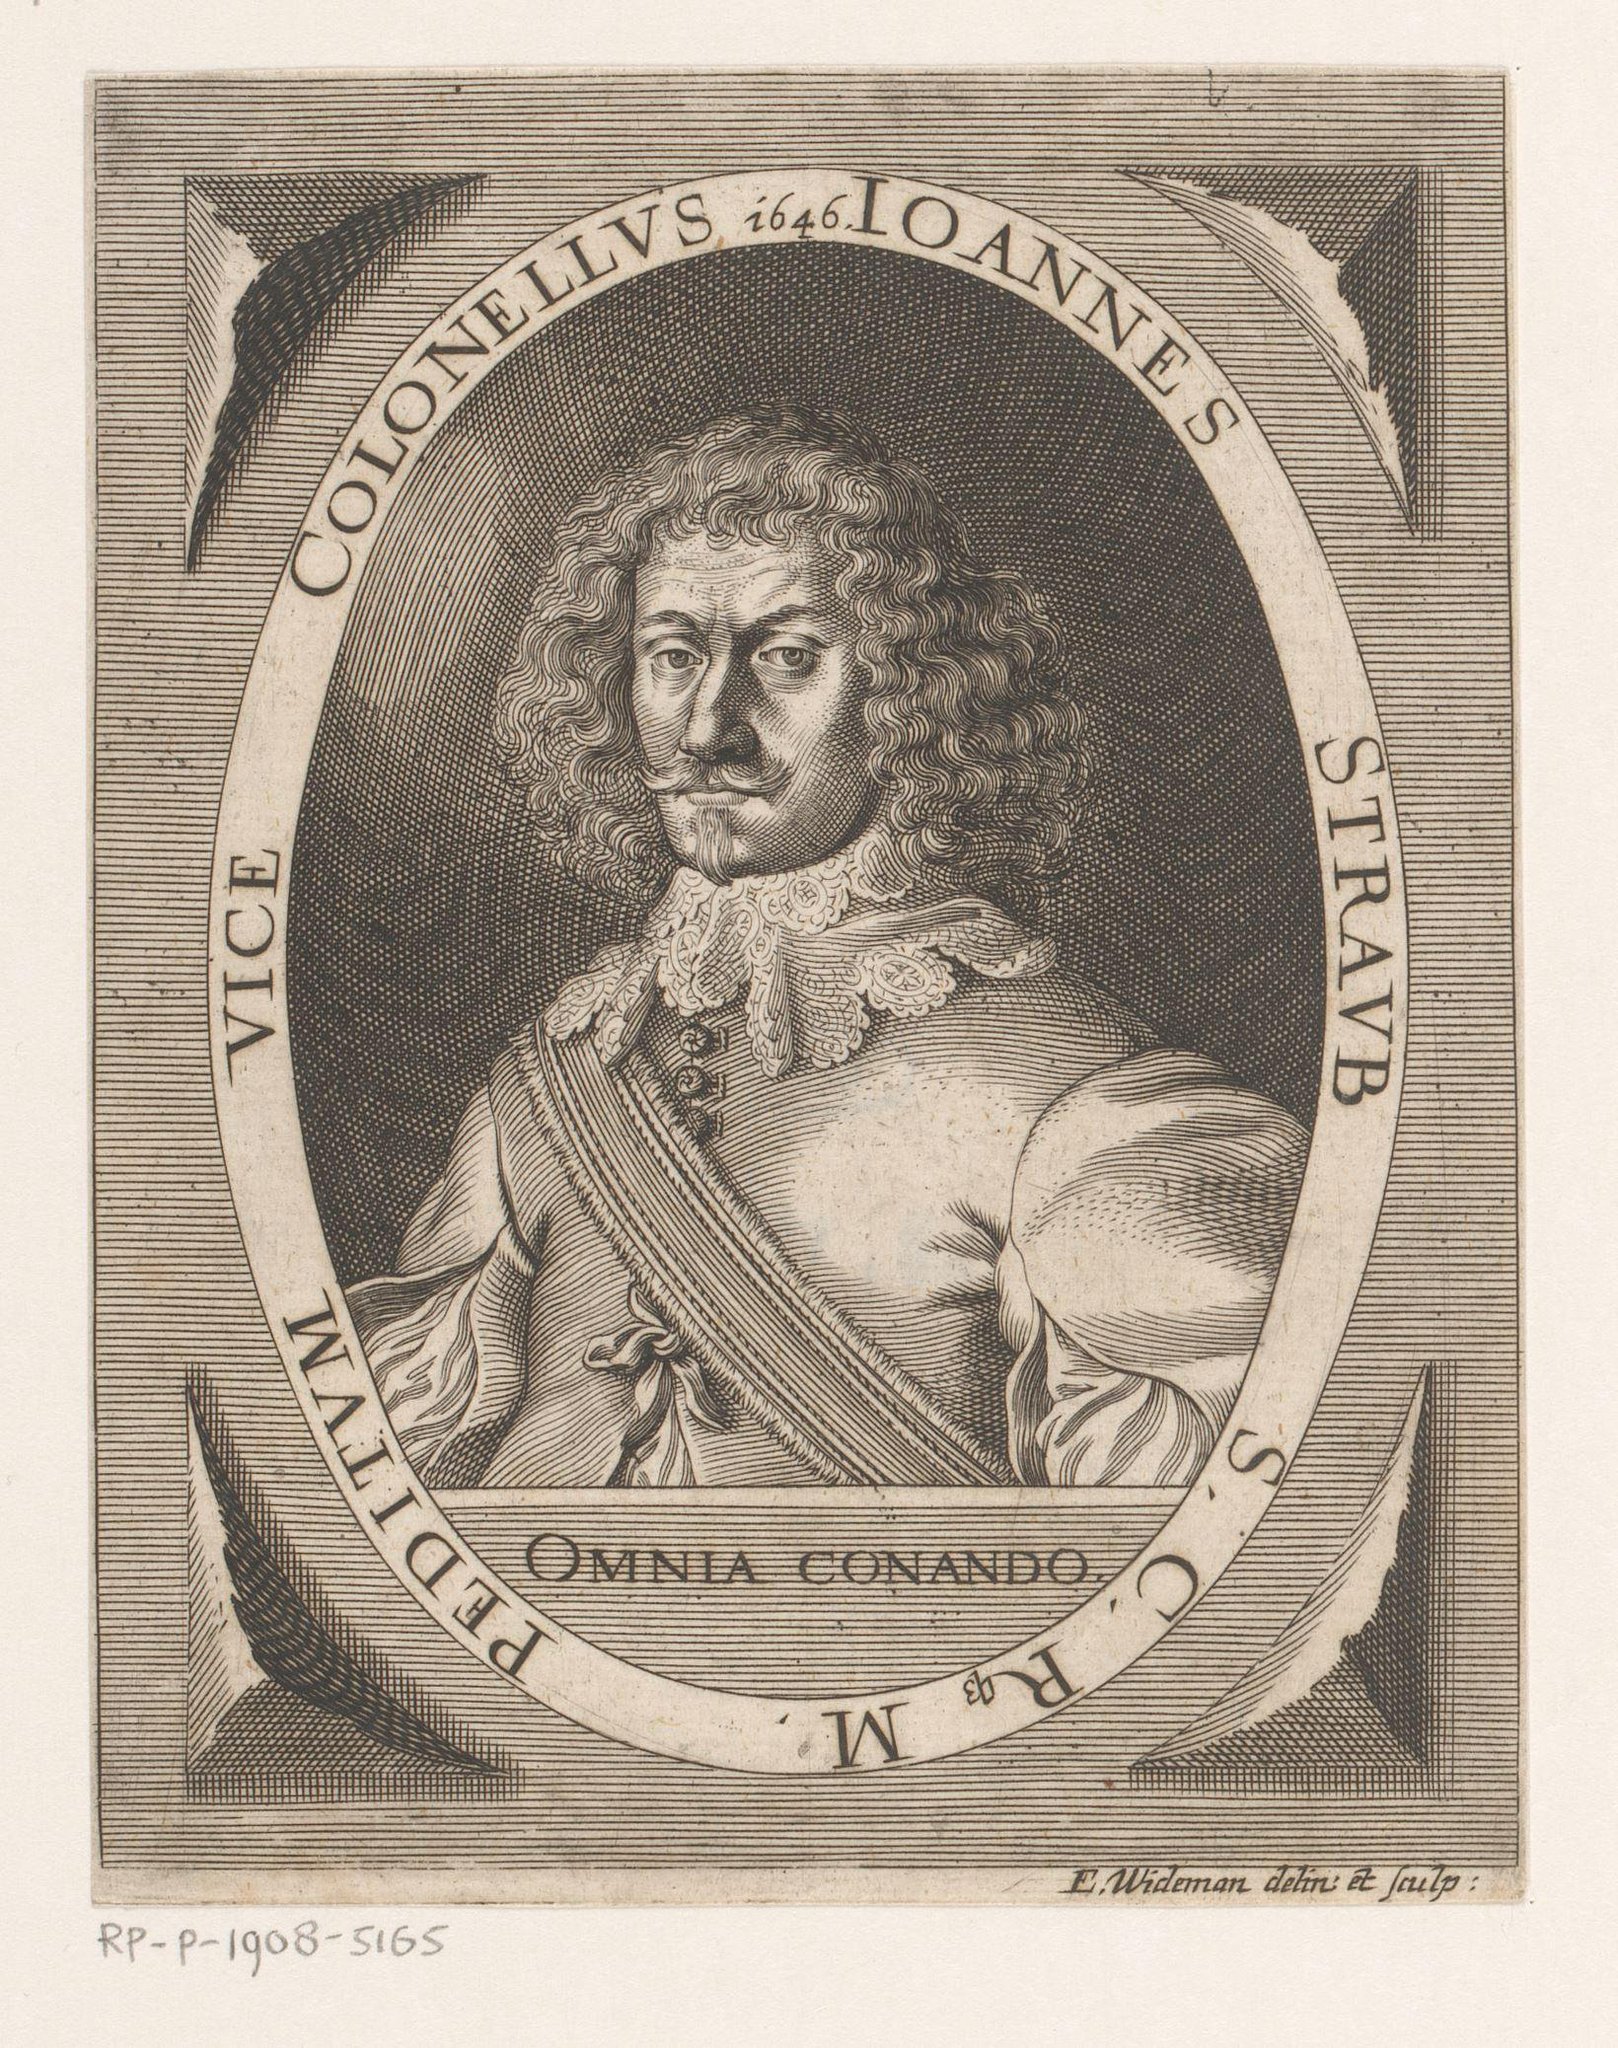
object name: print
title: Portret van Johannes Straub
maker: elias widemann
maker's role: print maker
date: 1646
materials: paper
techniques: engraving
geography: vienna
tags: historical persons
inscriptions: collector's mark: Lugt 2228